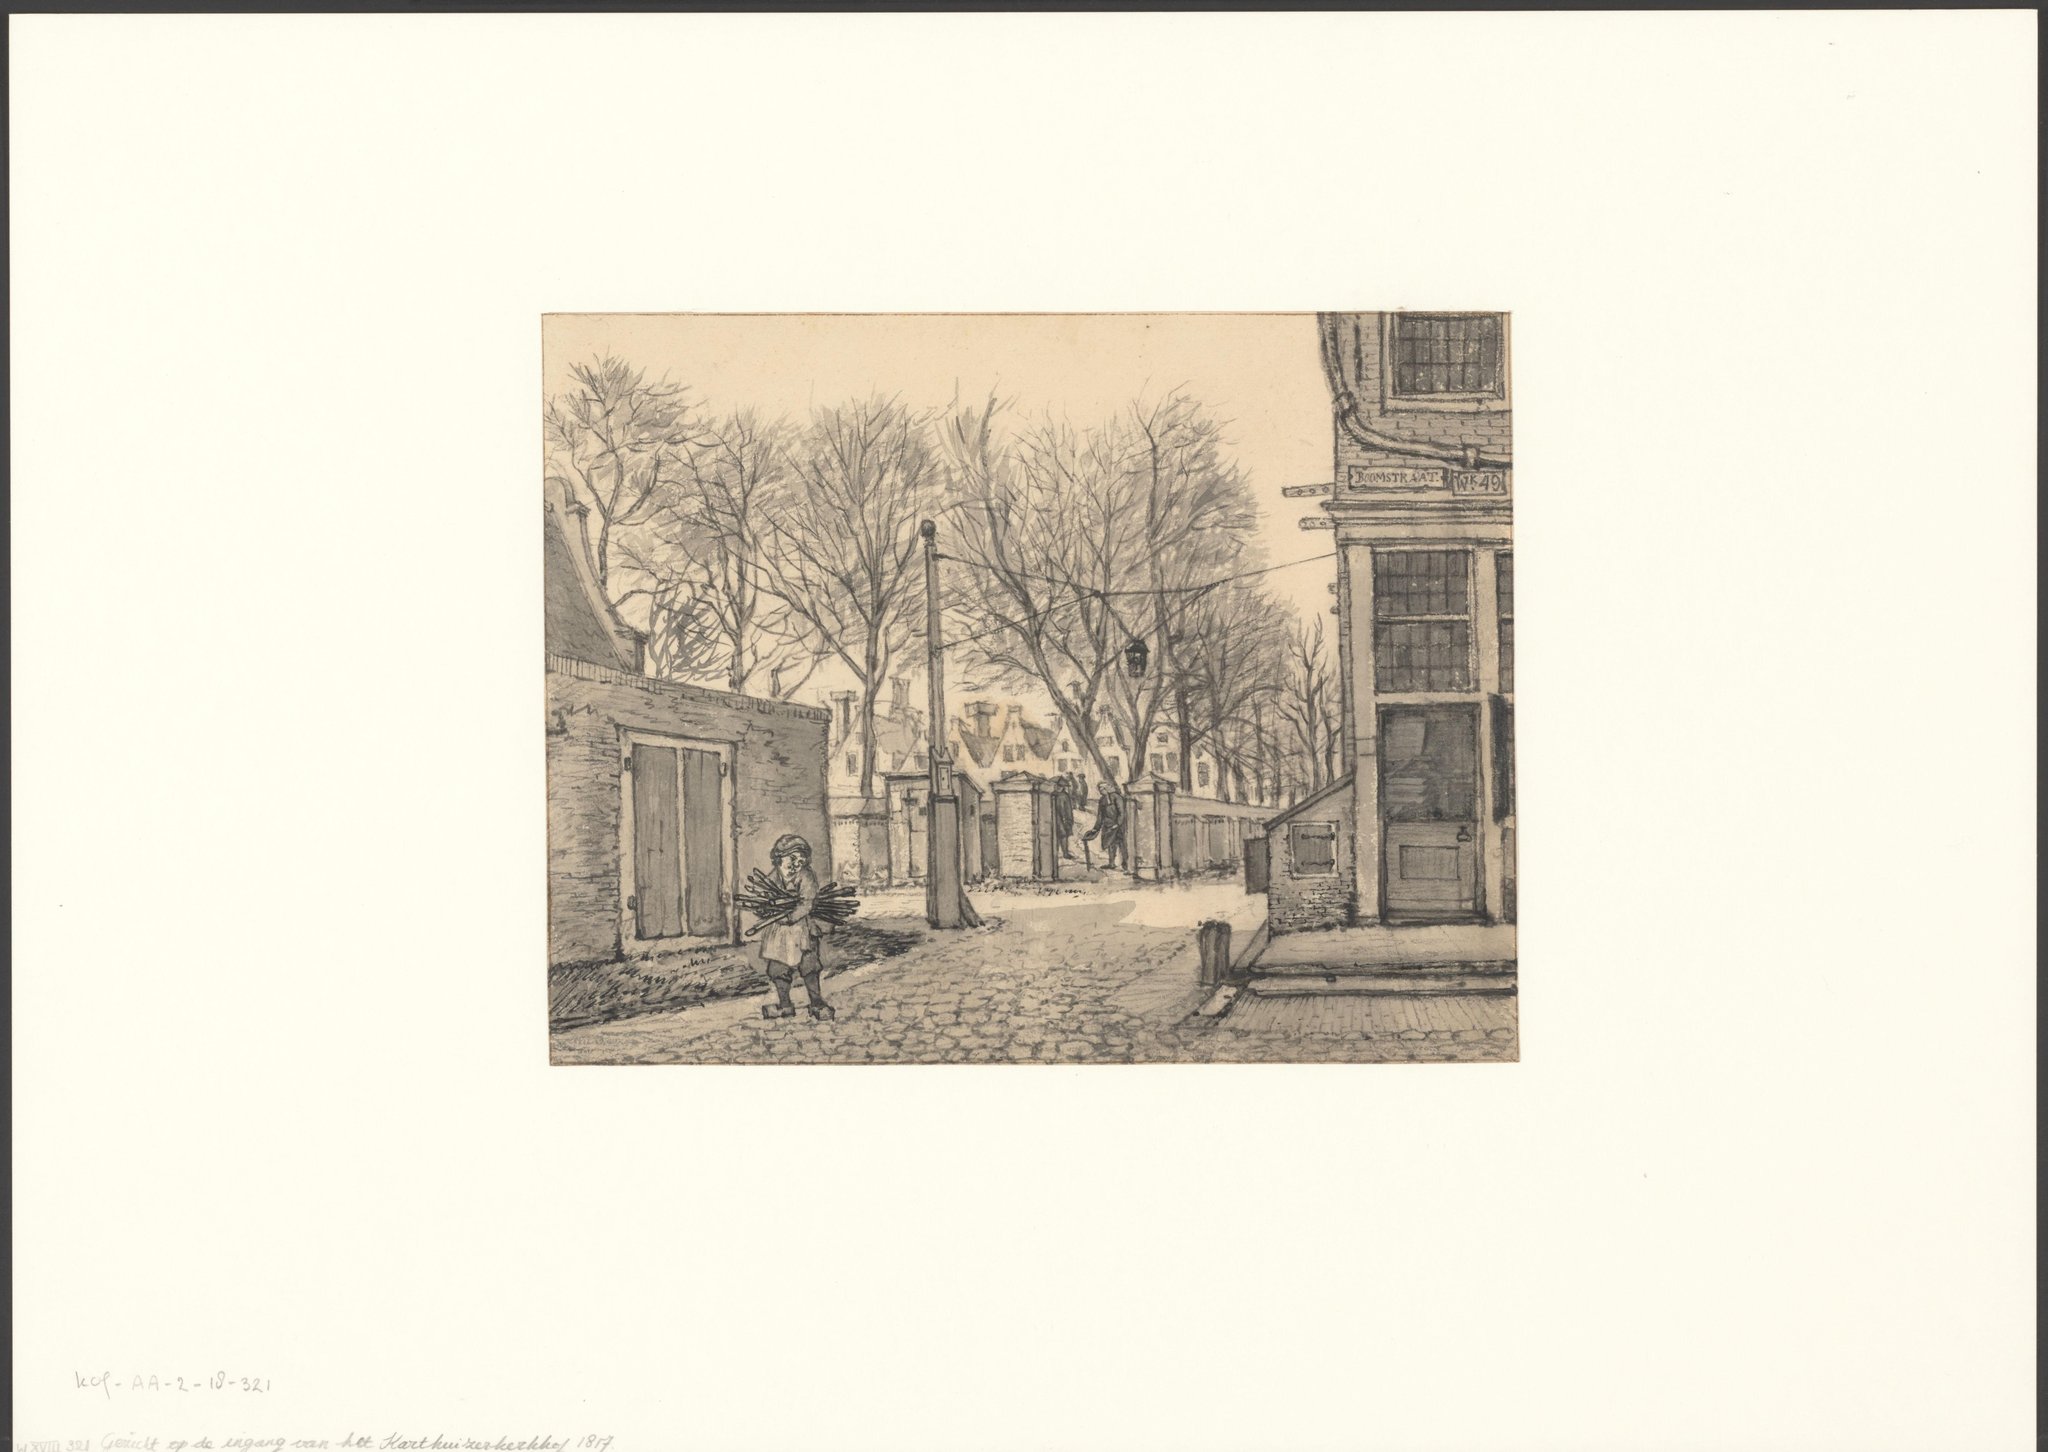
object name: drawing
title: Gezicht op de ingang van het Kartuizerkerkhof aan de Kartuizerstraat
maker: gerrit lamberts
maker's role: bookseller, draughtsman, print maker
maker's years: 1776-1850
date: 1817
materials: ink, paper, pencil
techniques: brush, pen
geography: amsterdam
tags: city-view in general; 'veduta', cemetery, park-like burying ground, street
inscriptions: signature and date: ‘G Lamberts. 1817.’, collector's mark: Lugt 2138d, inscription: ‘Gezigt op de (...) het Karthuizers Kerkhof’, collector's mark: Lugt 800a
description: Tekening binnen de Atlas Van Eck ingedeeld op wijknummer 18.